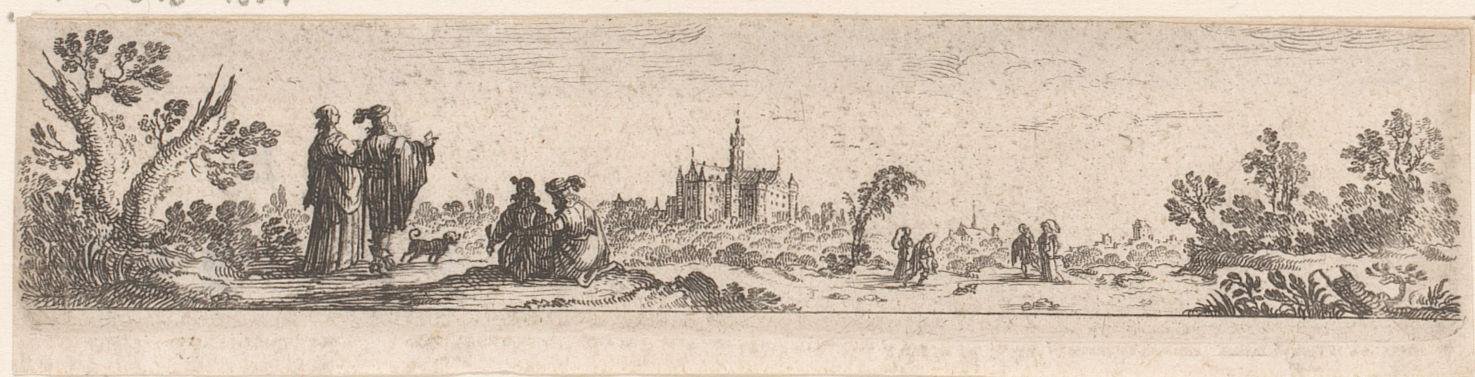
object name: print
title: Vignetten met buitentaferelen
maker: nicolas cochin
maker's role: print maker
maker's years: 1610-1686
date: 1620-1686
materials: paper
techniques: etching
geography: france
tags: walking, hiking (recreation), landscape with tower or castle